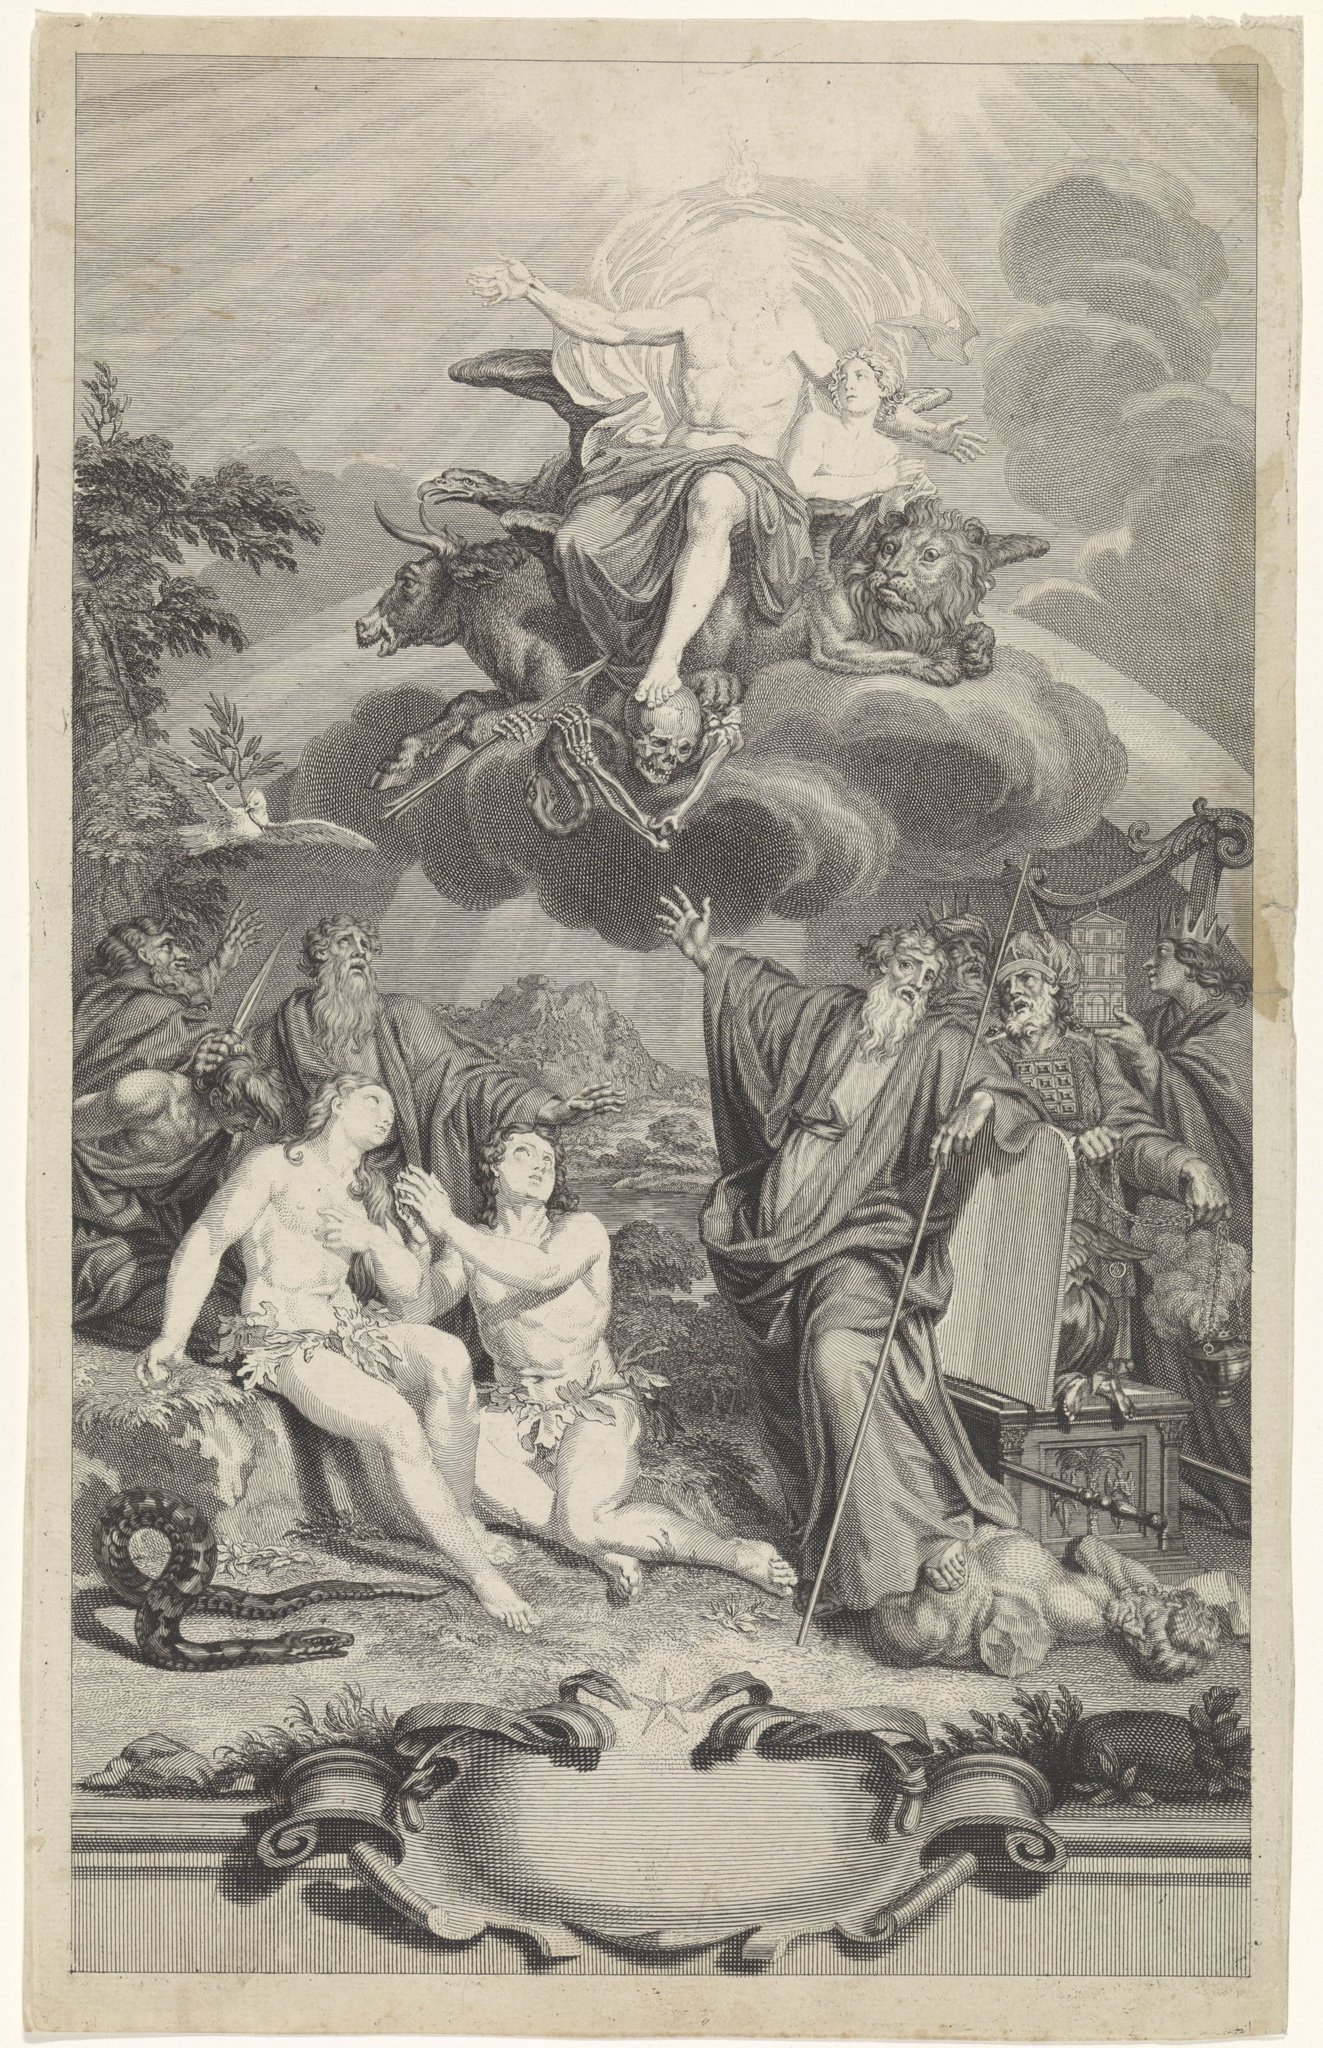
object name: print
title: Landschap met figuren uit het Oude Testament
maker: bernard picart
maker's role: draughtsman, print maker, publisher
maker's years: 1673-1733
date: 1720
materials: paper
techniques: engraving, etching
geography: amsterdam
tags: 'salvator mundi', making a blessing gesture; an orb in his hand or at his feet, the dove returns with an olive-branch ~ story of noah, the sacrifice of isaac (genesis 22), david as musician, usually playing the harp, death as skeleton, the four symbols of the evangelists, 'the apocalyptic beasts', aaron (not in biblical context); possible attributes: attributes of aaron: censer, dressed as high priest or bishop, ointment jar, rod or flowering wand, moses (not in biblical context); possible attributes: rays of light or horns on his head, rod, tables of the law, adam and eve (not in biblical context), tetragram (in roman or hebrew script) ~ symbol of god the father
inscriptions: collector's mark: Lugt 2228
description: Allegorische voorstelling met figuren uit het Oude Testament. Links Adam en Eva, Isaak en Abraham en Noach. Rechts Mozes en Aäron en koning David. Christus troont op een wolk in de hemel, omringd door de symbolen van de vier evangelisten. Boven zijn hoofd brandt de vlam van geloofsijver. Hij vertrapt de Dood (als skelet). In de hemel een tetragram als symbool van God de Vader.